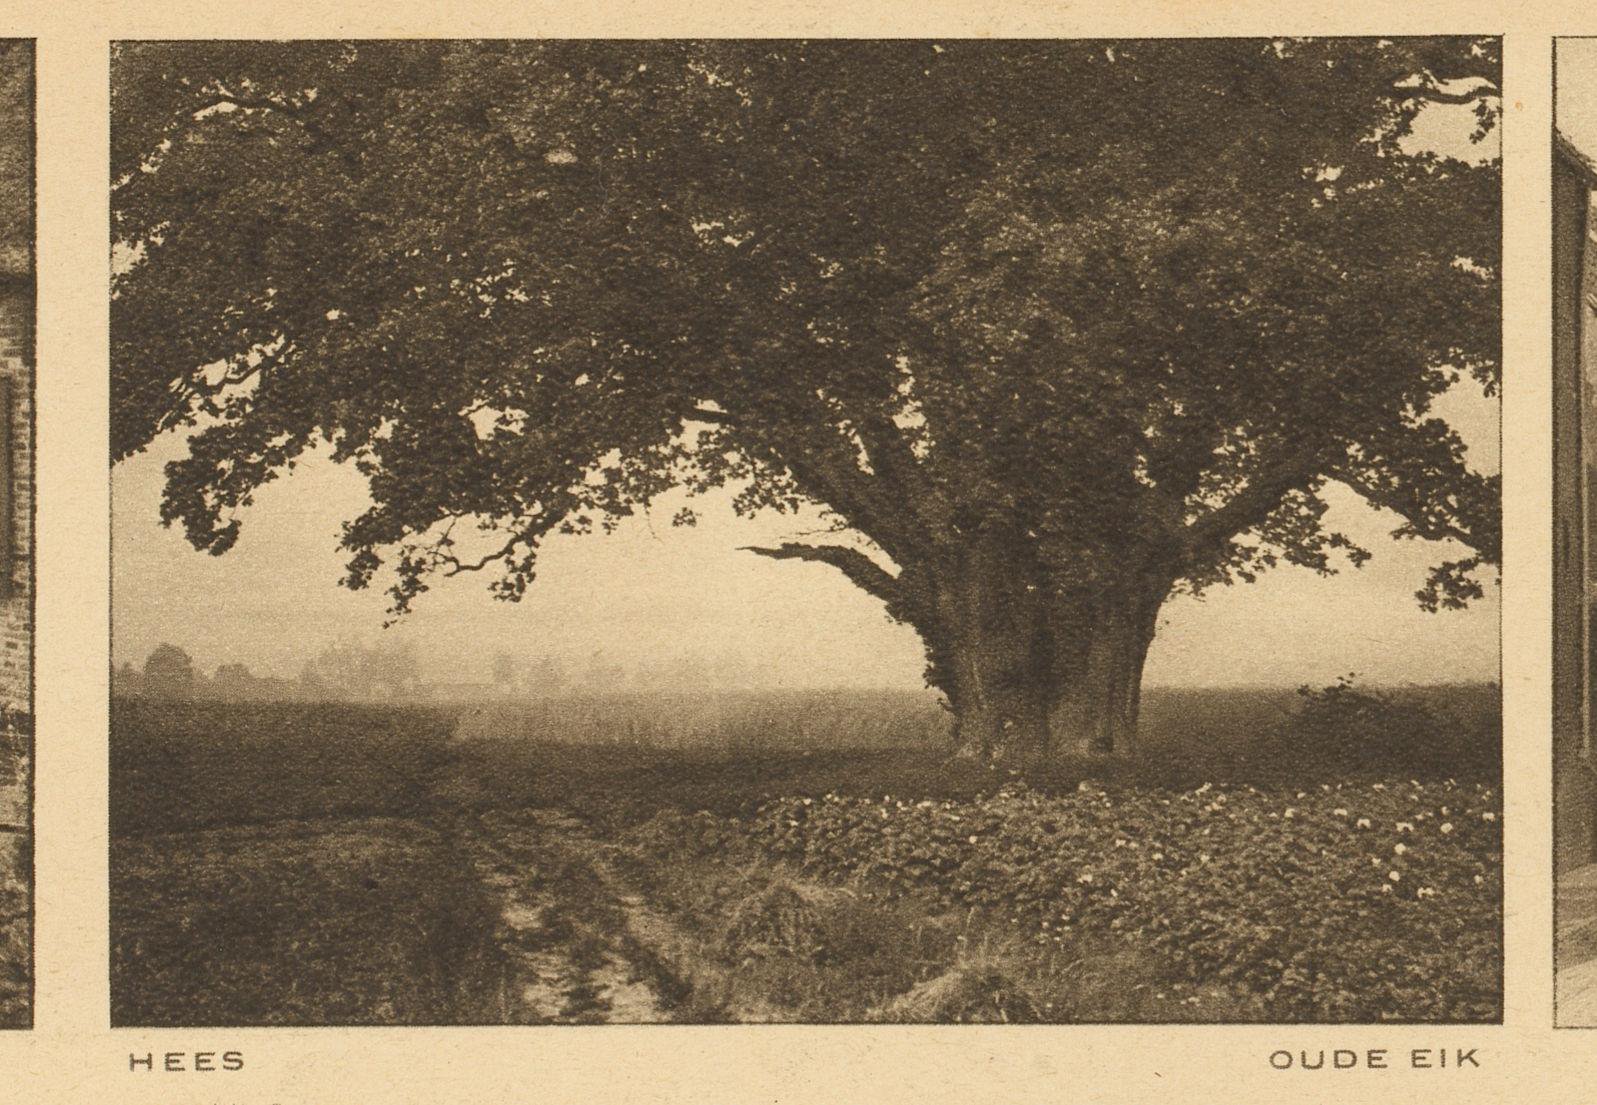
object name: album leaf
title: Hees - Oude eik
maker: Anonymous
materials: paper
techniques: rotogravure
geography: leiden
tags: landscapes, trees: oak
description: Deze prent maakt deel uit van een album.